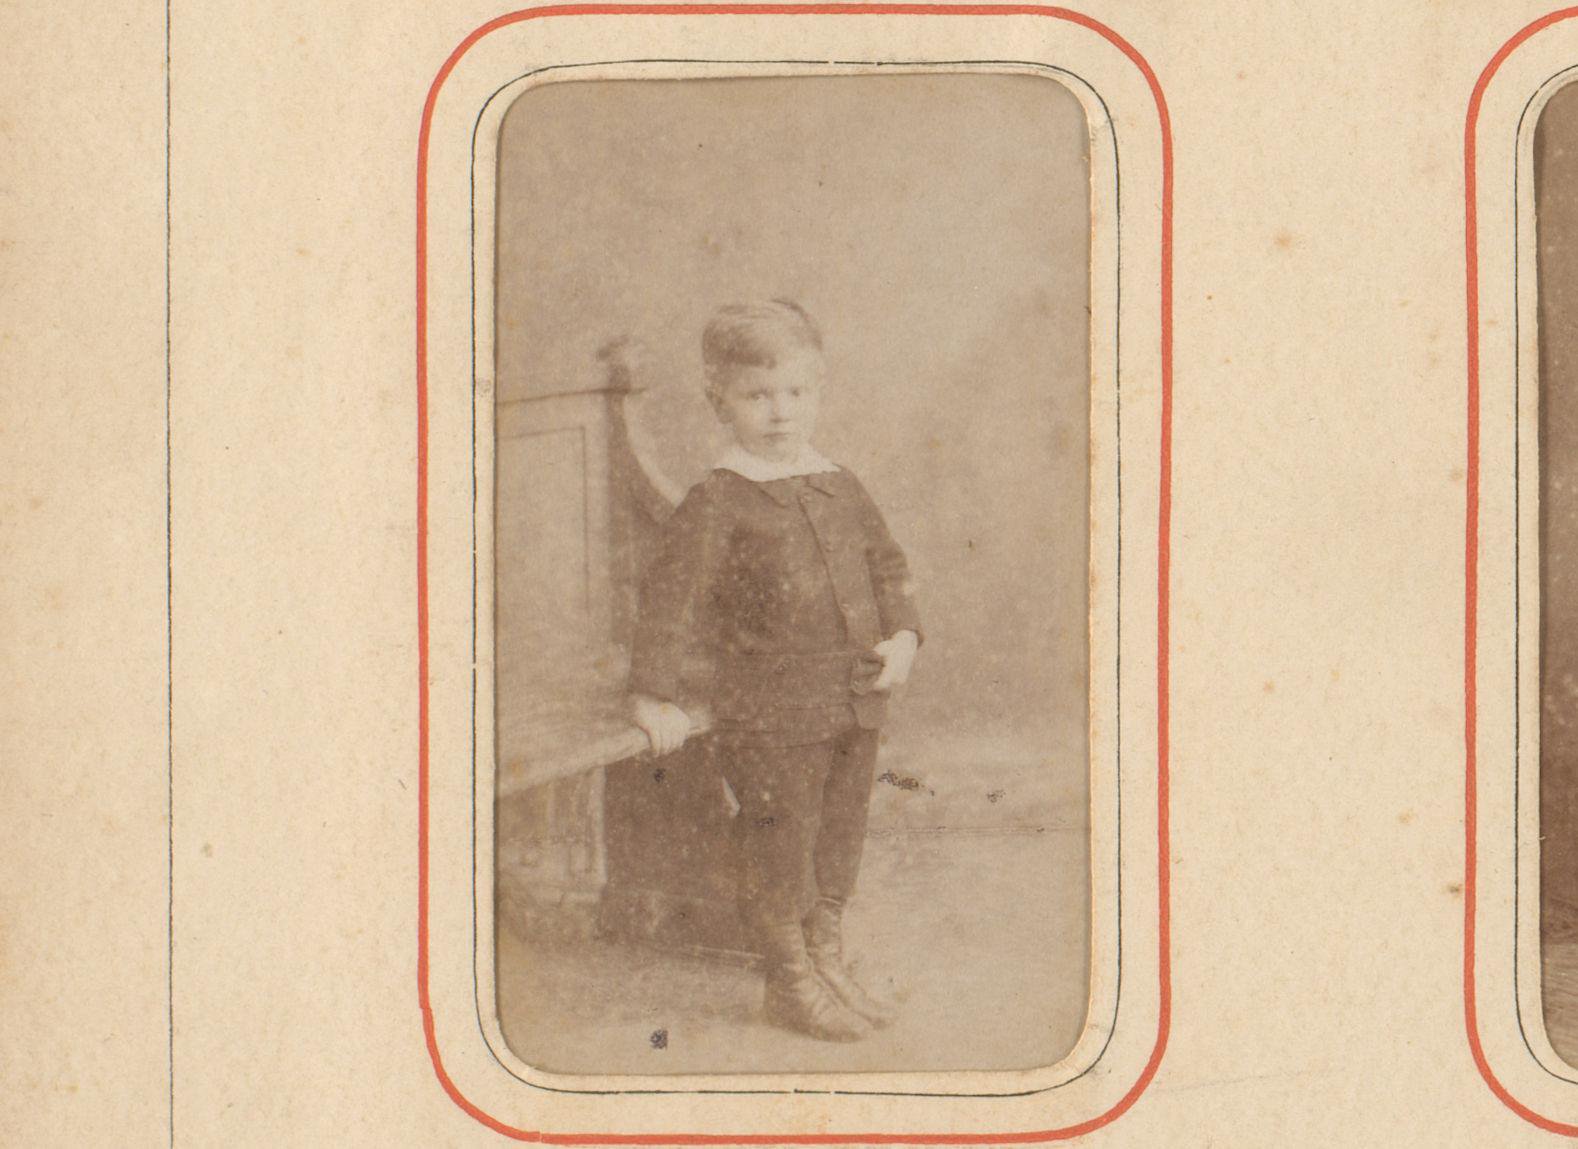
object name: photograph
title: Portret van een onbekend kind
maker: bernardus bruining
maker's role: fotograaf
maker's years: 1834-1900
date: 1880-1890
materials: cardboard, paper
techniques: albumen print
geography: arnhem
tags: anonymous historical person portrayed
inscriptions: address: ‘Steenstraat/ Arnhem.’